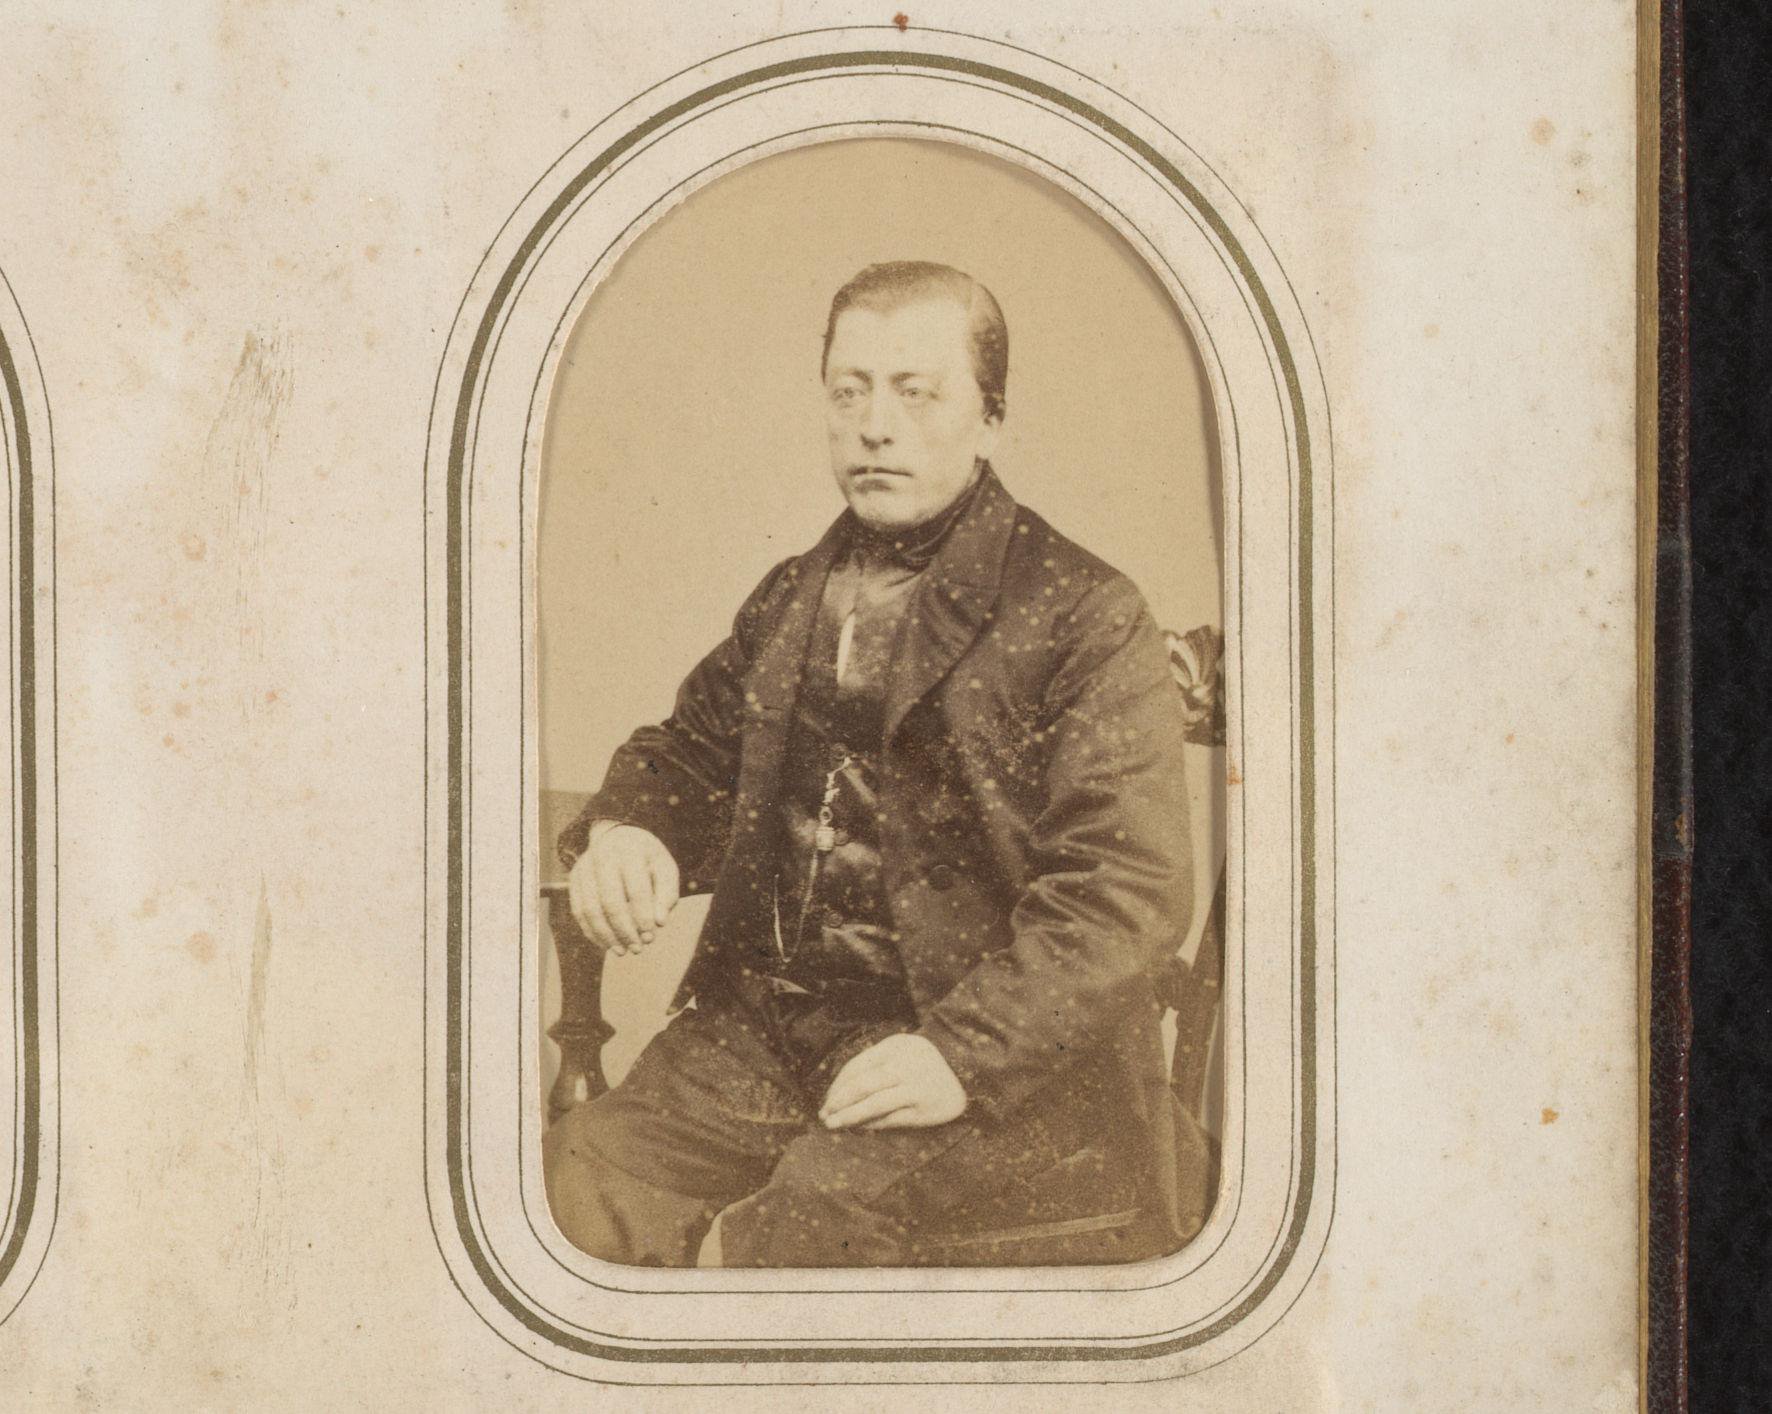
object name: photograph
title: Portret van een zittende man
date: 1860-1880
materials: cardboard, photographic support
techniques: albumen print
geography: hoorn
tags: sitting figure, historical persons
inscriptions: inscription: ‘Photographisch Atelier/ F.D. VAN ROSMALEN & Co./ aan het groote Oost/ en/ in de Nieuwe steeg/ te/ HOORN.’